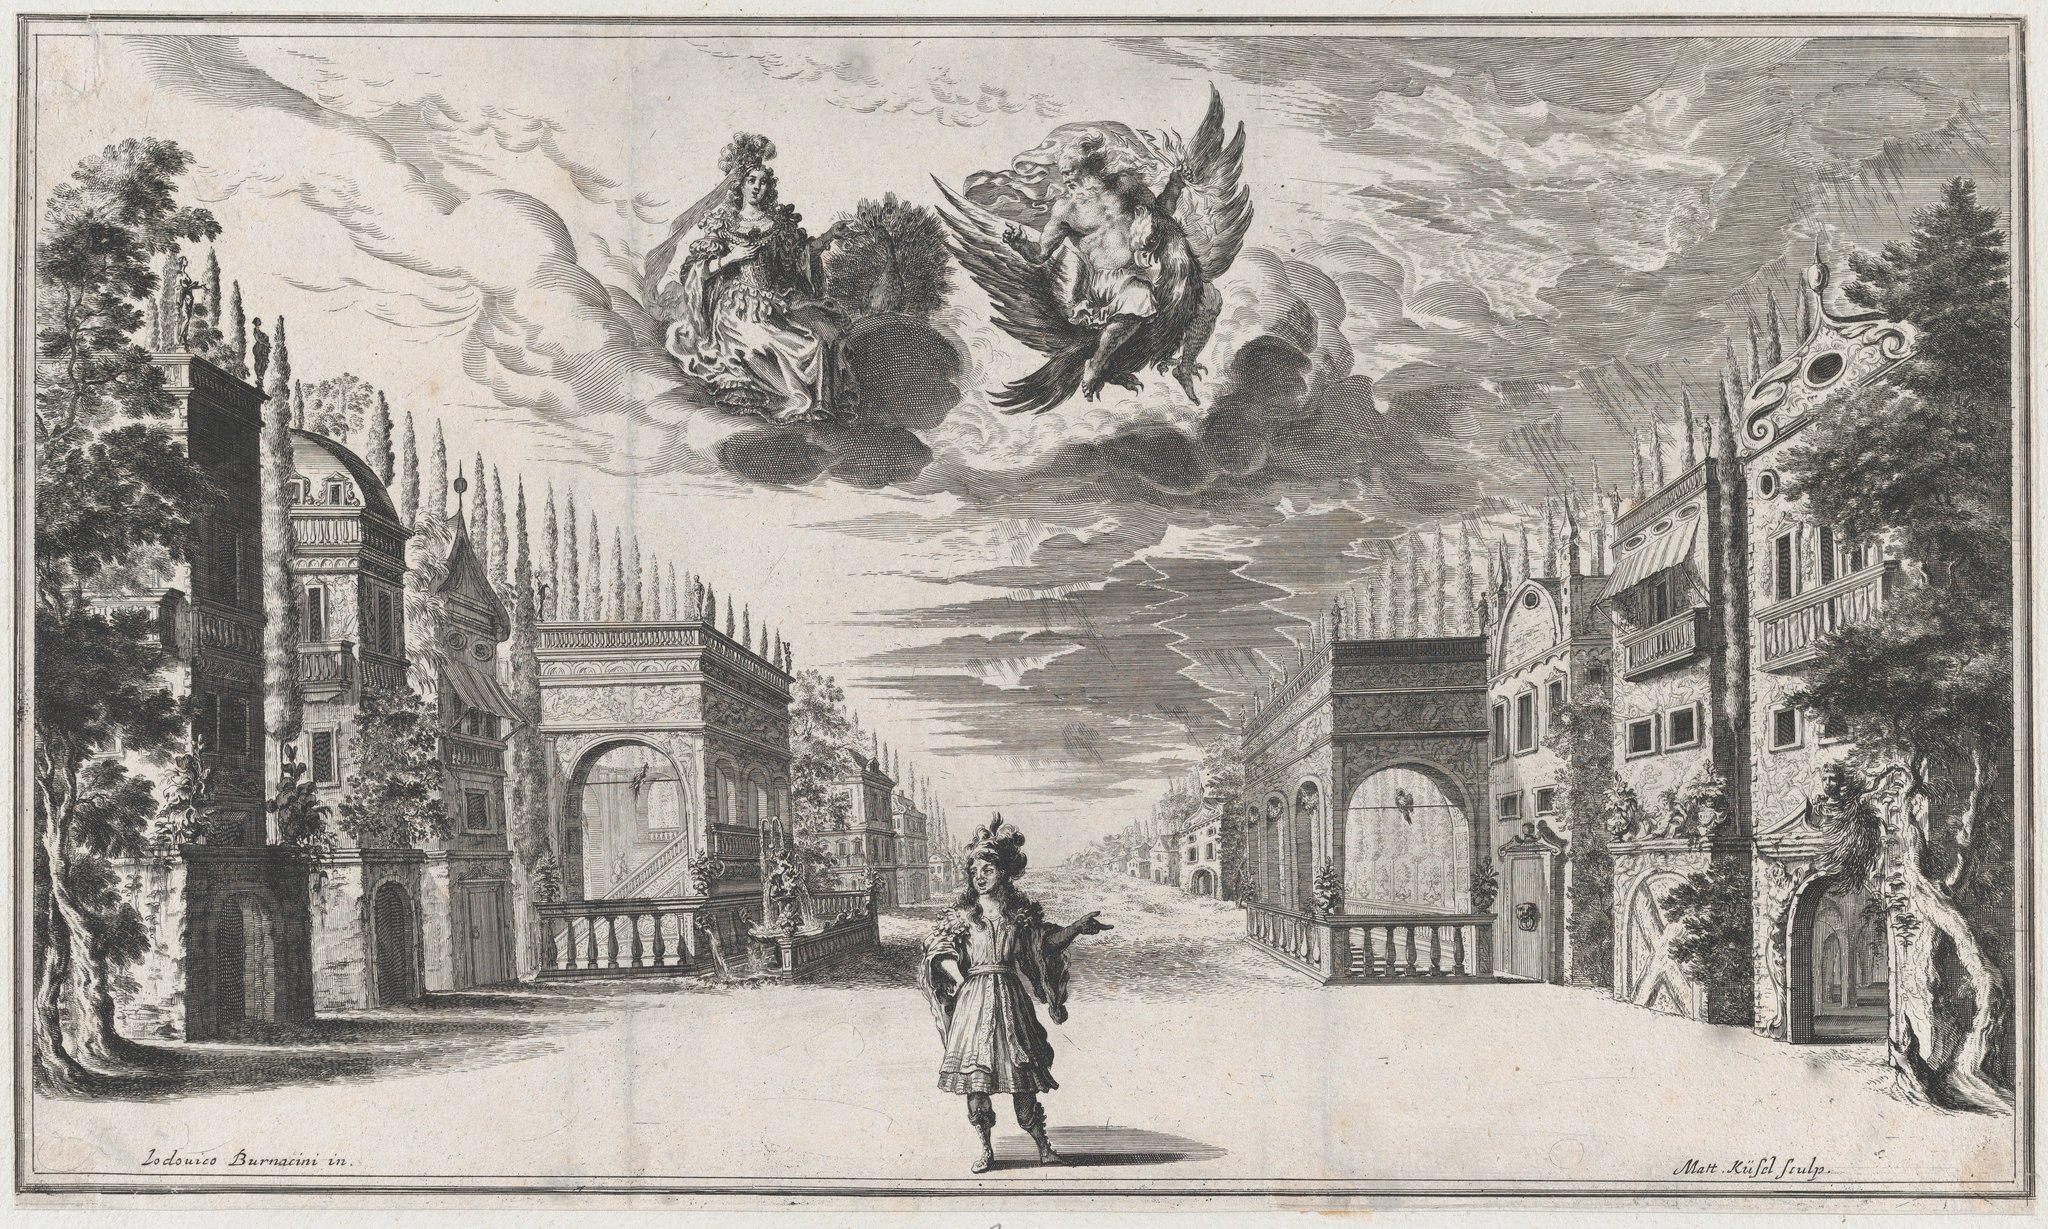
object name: print, fete, ornament architecture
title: A man stands at center, flanked by rows of buildings; above Jupiter atop an eagle and Juno accompanied by a peacock, converse among the clouds; set design from 'Il Pomo D'Oro'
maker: mathäus küsel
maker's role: artist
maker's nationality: german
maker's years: 1621-1682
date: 1668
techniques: engraving, etching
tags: buildings,men,juno,jupiter